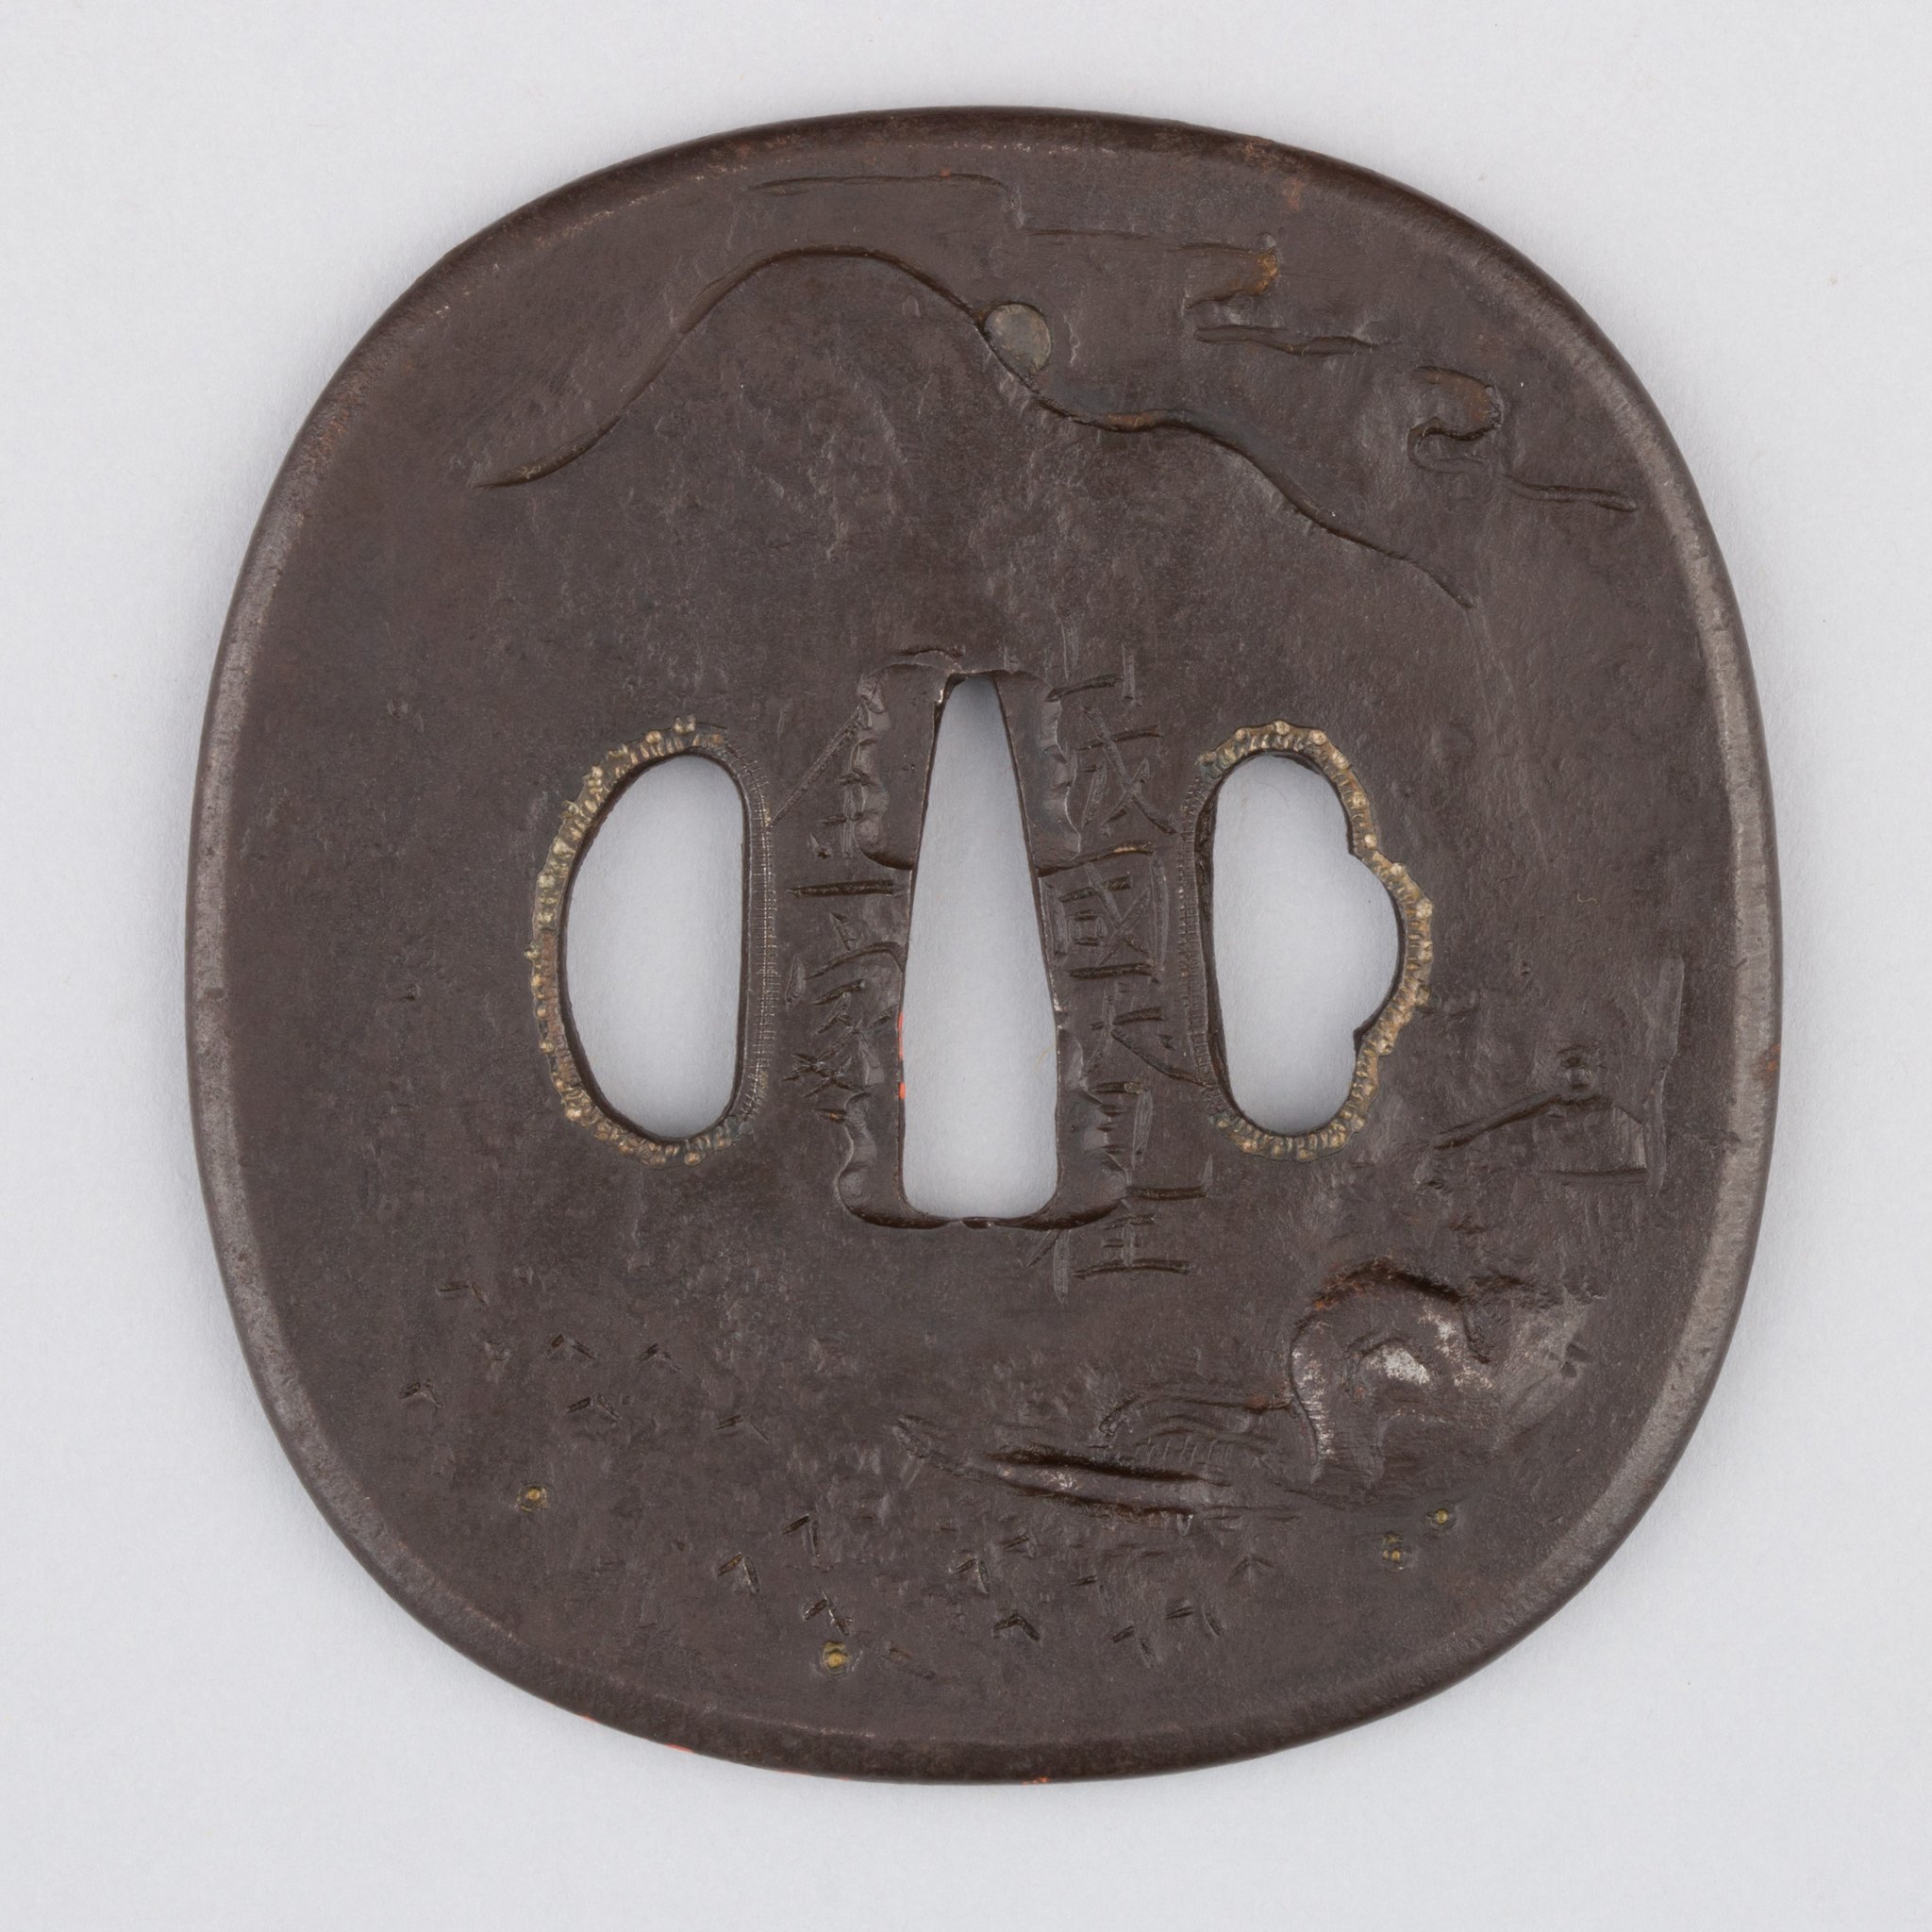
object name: sword guard tsuba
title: Sword Guard (Tsuba)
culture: japanese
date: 1615-1868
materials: copper, iron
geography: japan